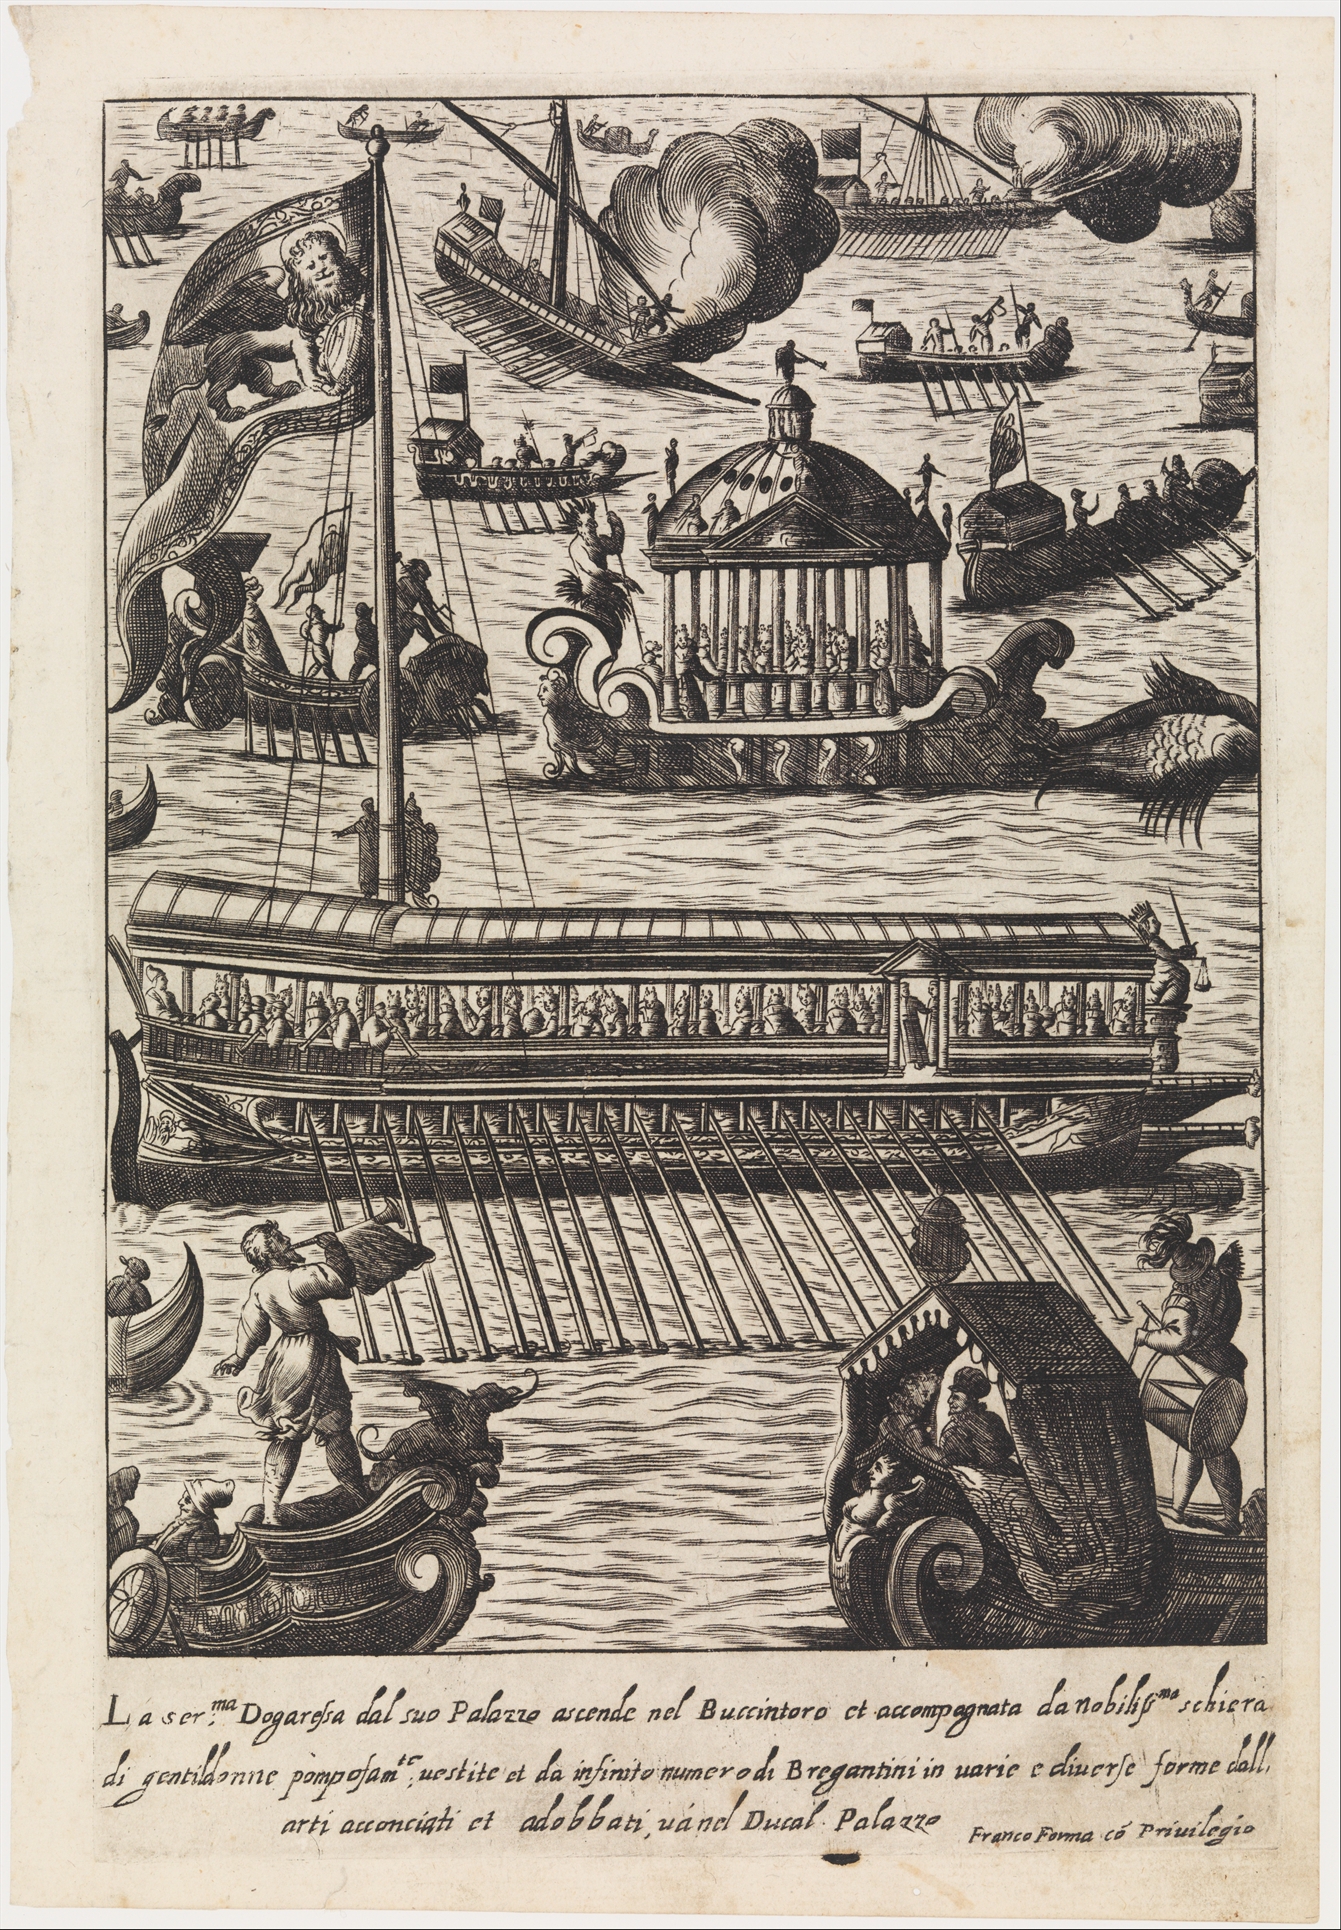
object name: print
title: La serenissima Dogaressa dal suo palazzo...Bucintoro from Habiti d'huomeni et donne Venetiane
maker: giacomo franco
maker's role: artist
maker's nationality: italian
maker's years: 1550-1620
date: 1610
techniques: engraving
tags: musical instruments,men,flags,ships,venice